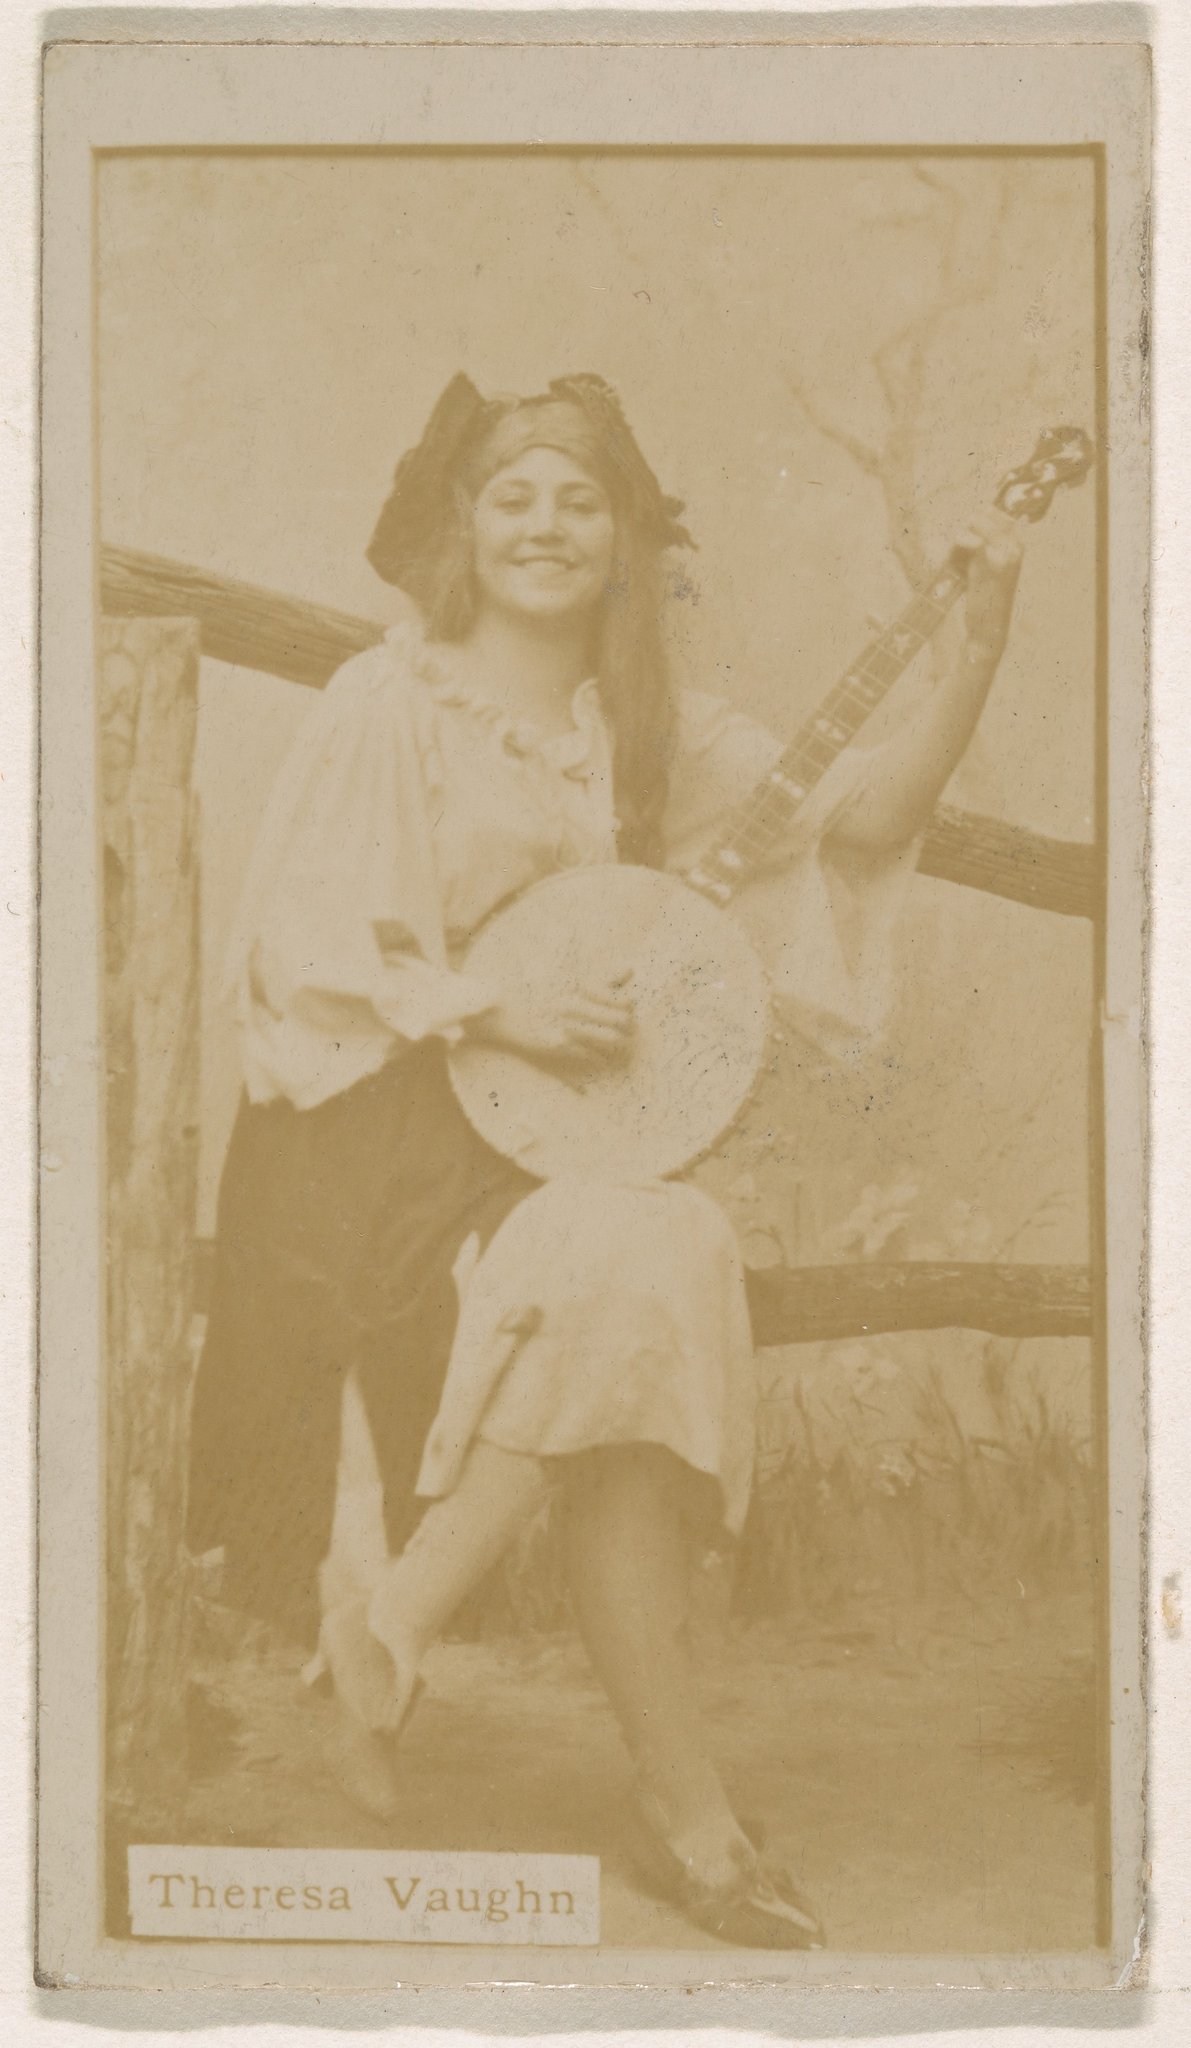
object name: photograph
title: Theresa Vaughn, from the Actresses series (N245) issued by Kinney Brothers to promote Sweet Caporal Cigarettes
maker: kinney brothers tobacco company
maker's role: publisher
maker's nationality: american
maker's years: 1869-2011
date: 1890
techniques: albumen silver print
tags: musical instruments,portraits,women,actresses